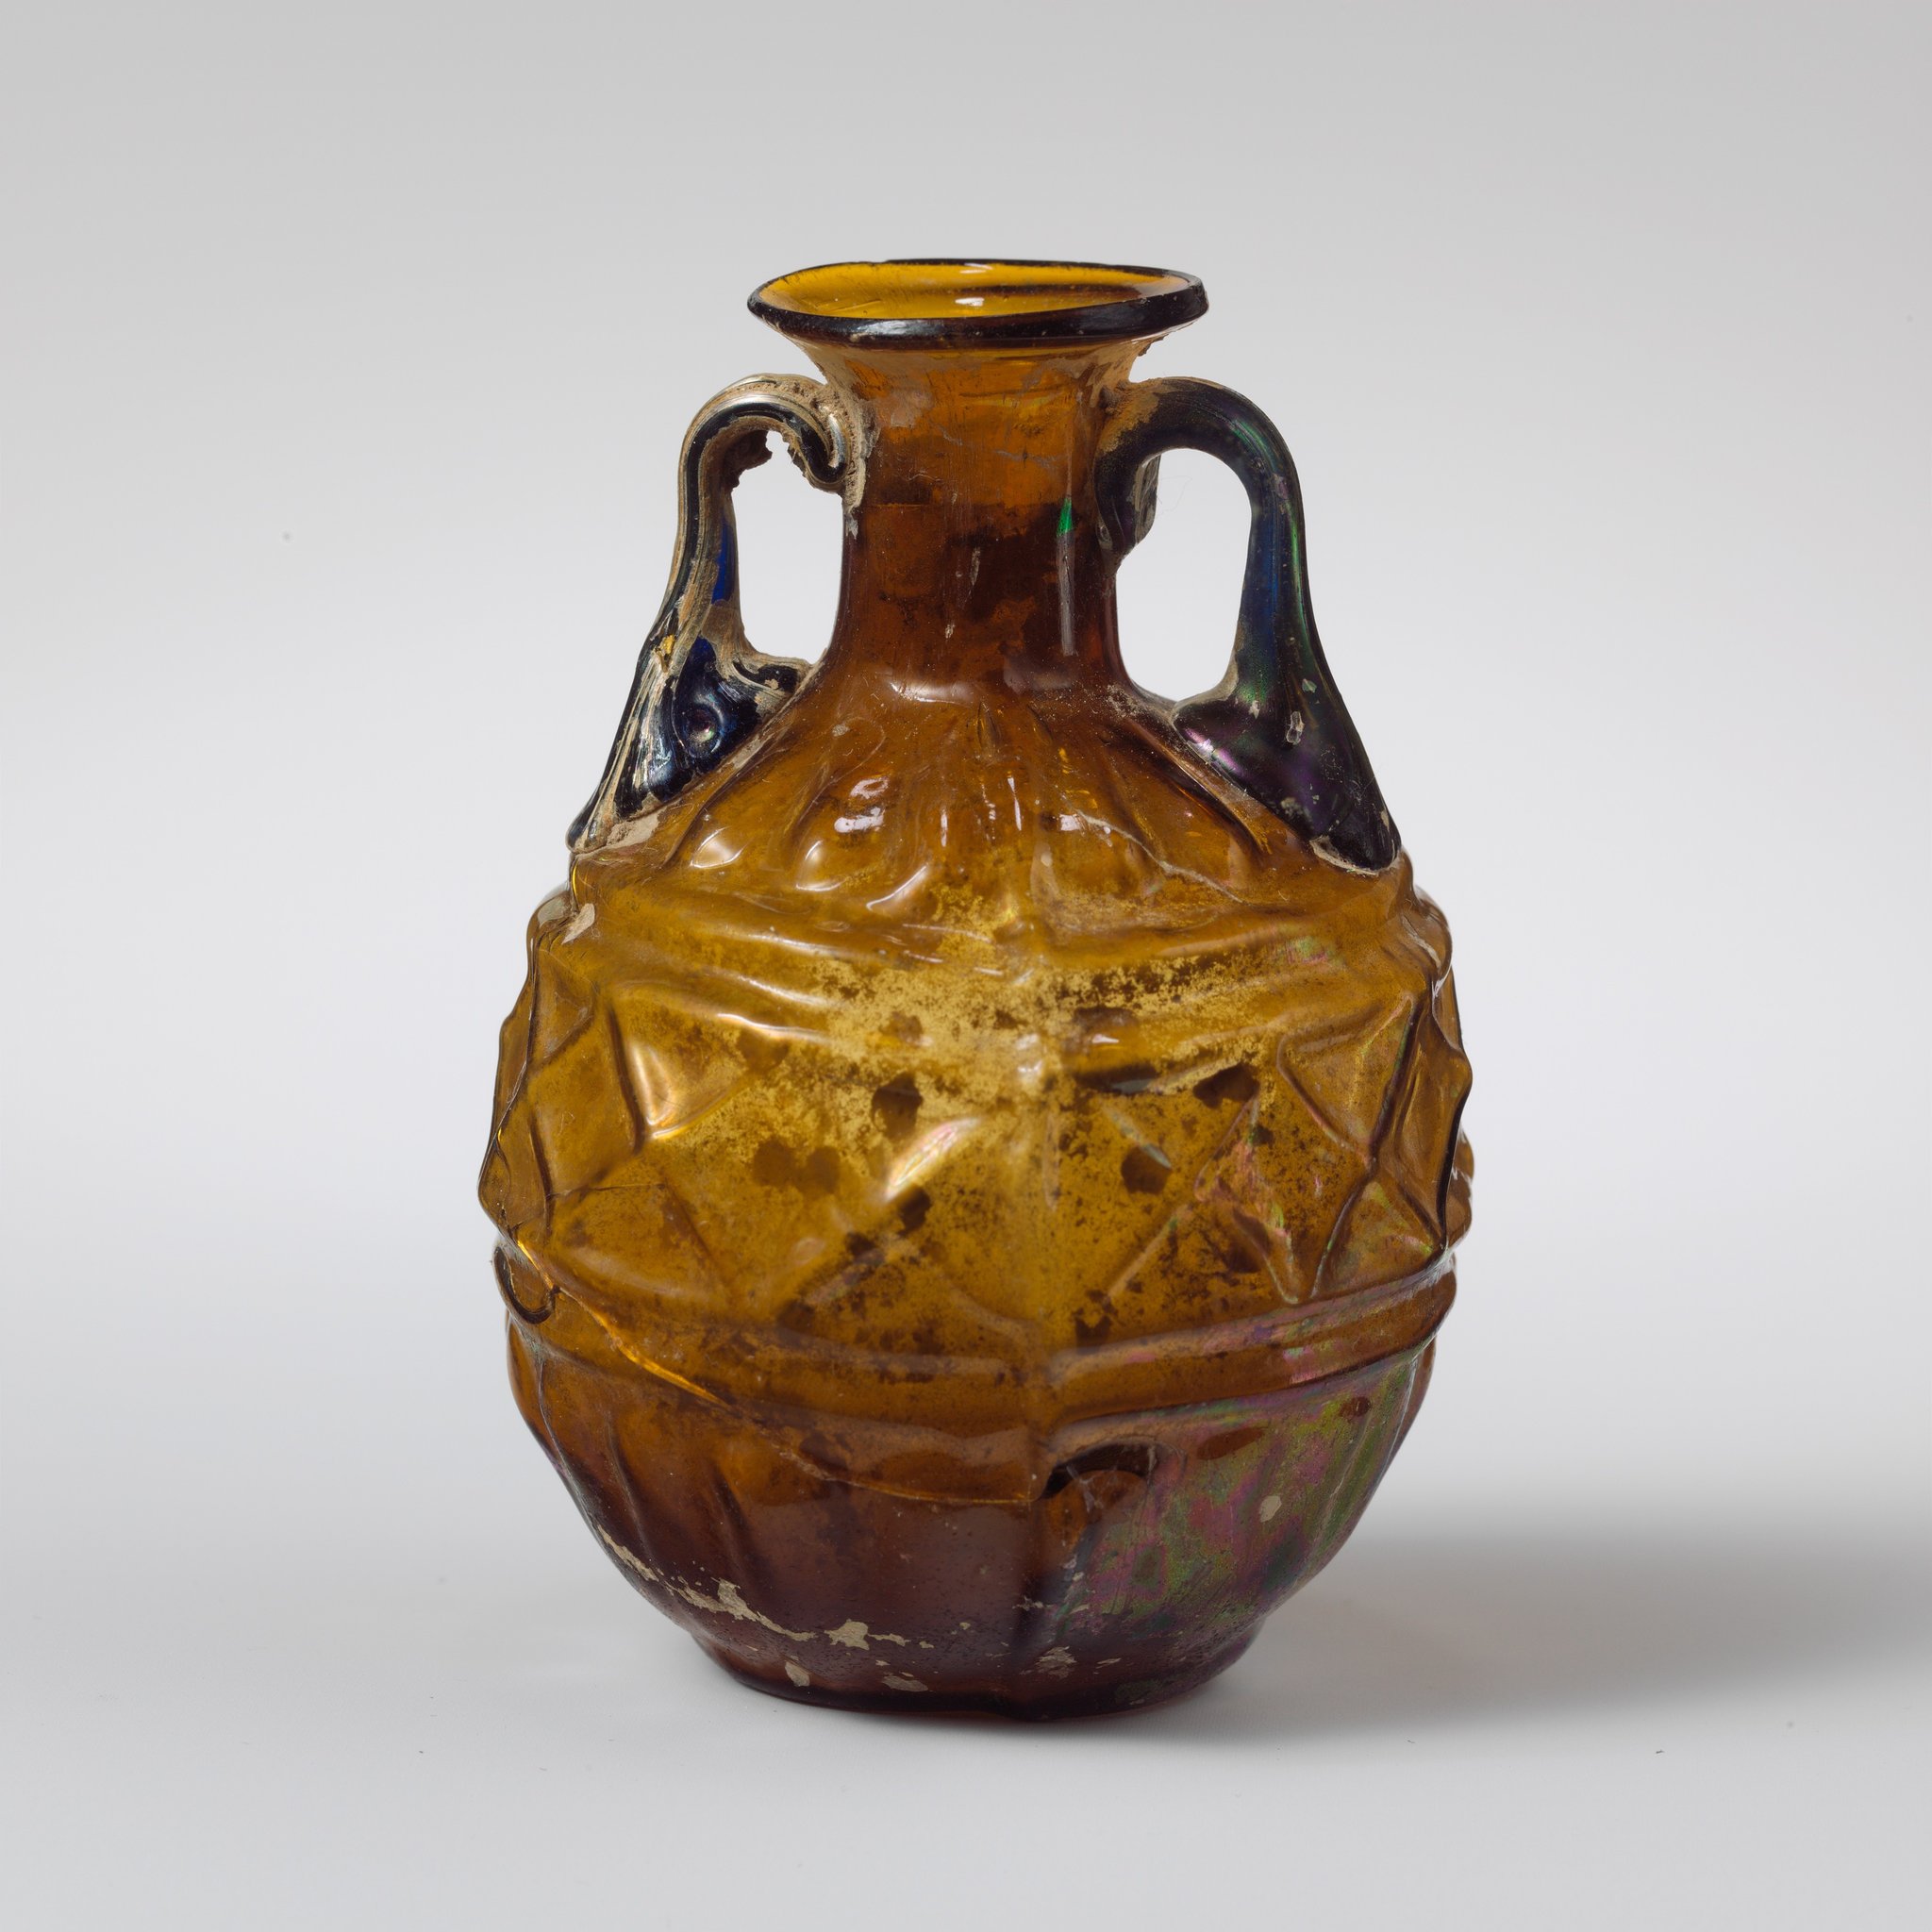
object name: amphoriskos, lozenge band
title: Glass amphoriskos (perfume flask) with band of lozenges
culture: roman, syro-palestinian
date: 1-100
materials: glass